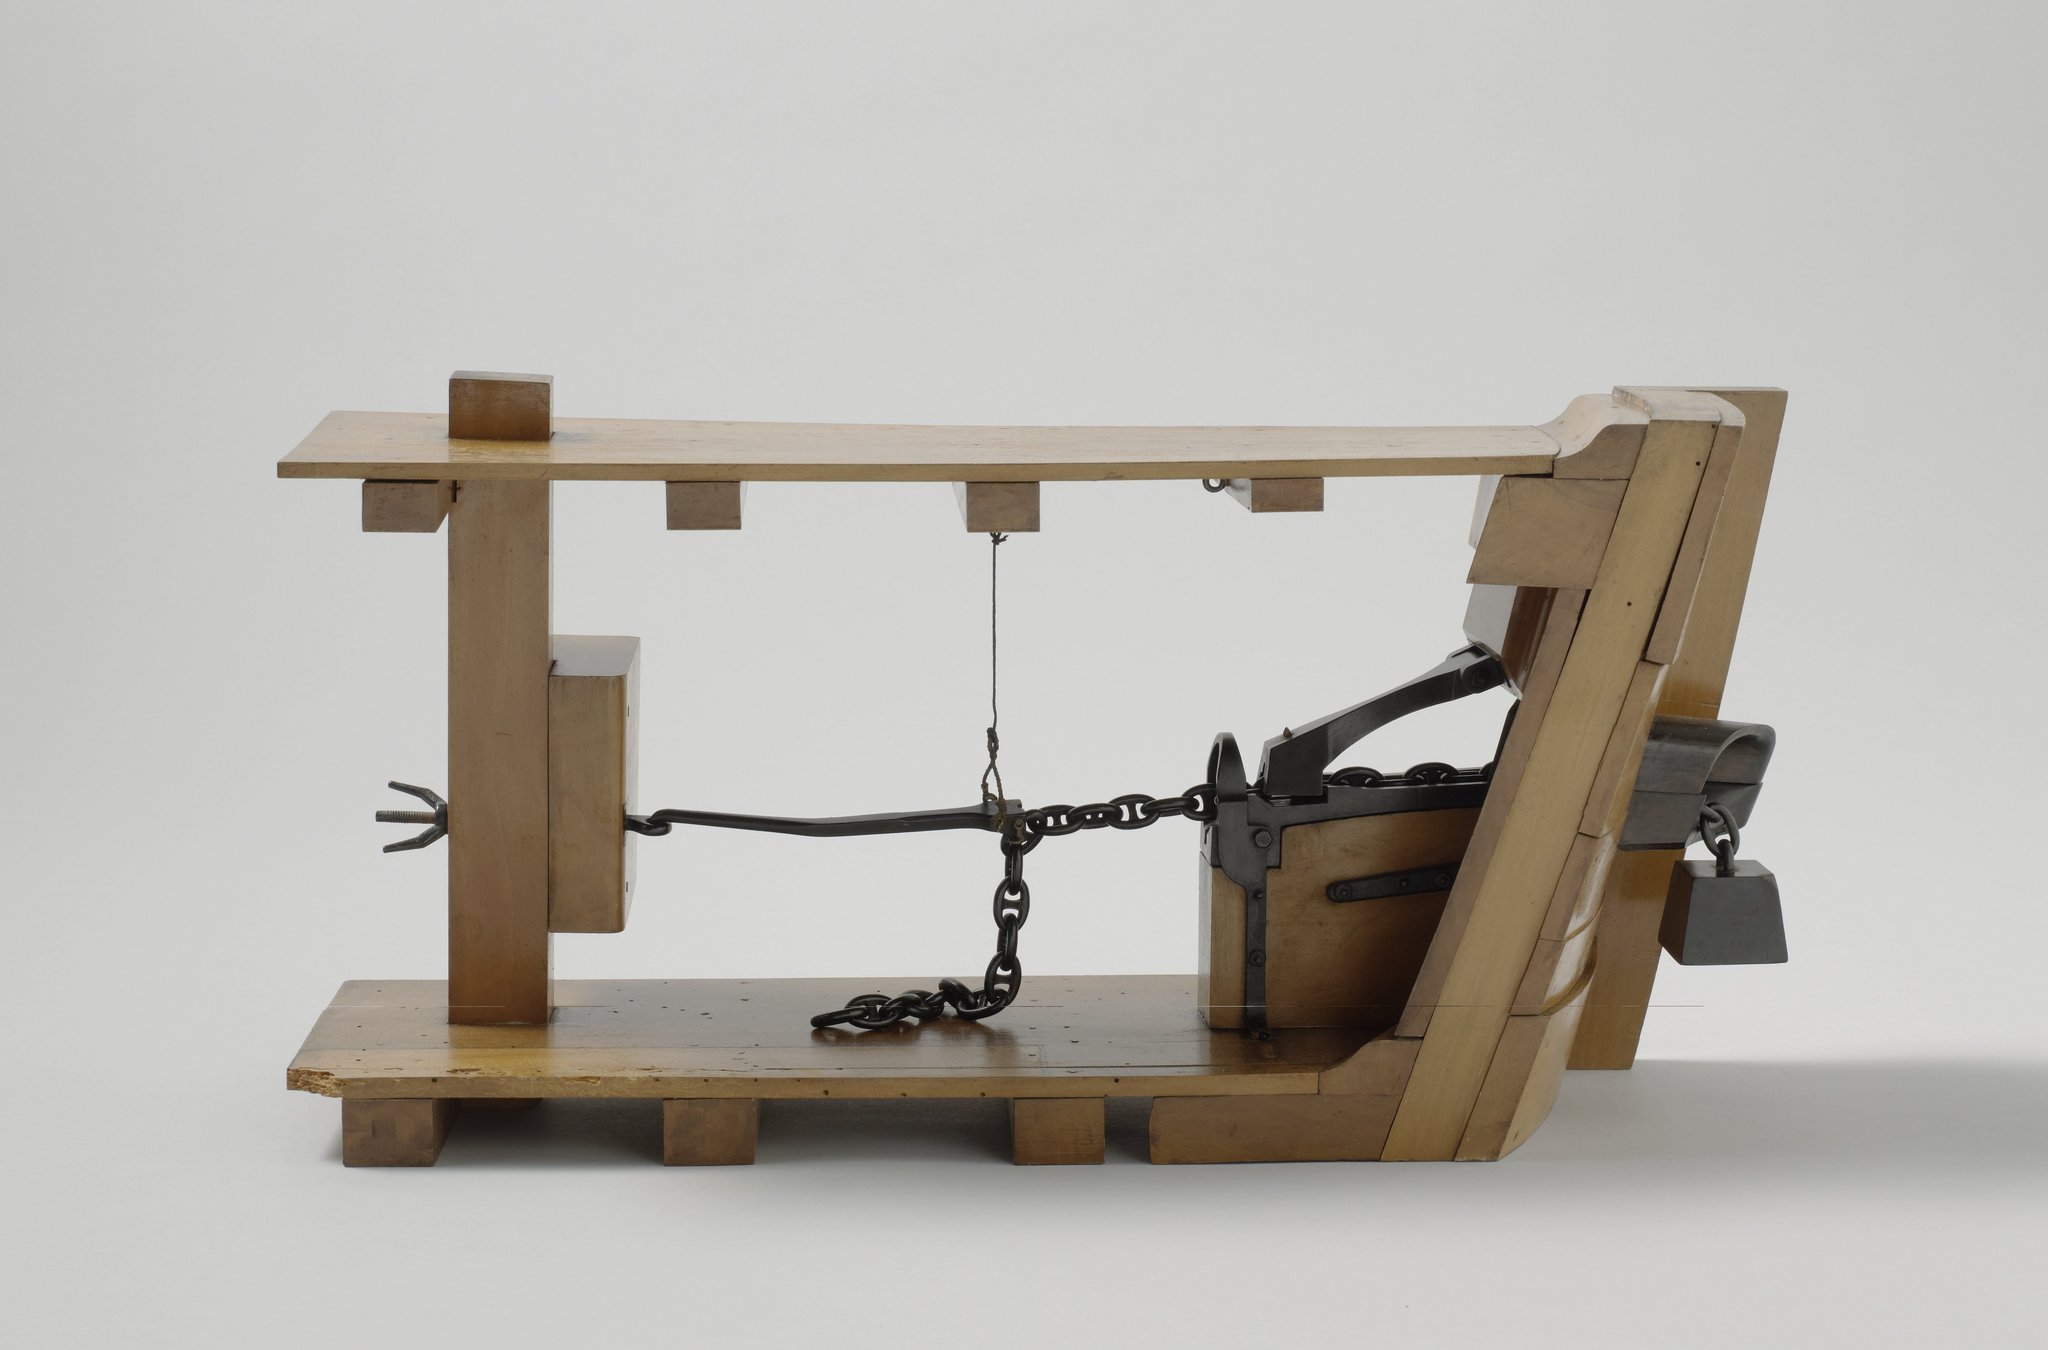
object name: demonstration model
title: Model of a Stopper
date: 1833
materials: wood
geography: flushing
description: Model van een ankerstopper tussen twee dekken, bestaande uit een glijbaan voor de ketting op een klos en doorlopend door het stuurboord kluisgat, en een zware duivelsklauw hangend aan een klos aan de scheepswand. Een lichte duivelsklauw hangt aan een dekbalk en aan een zware klos tegen een dekstut. Een houten ketting met namaakgewicht is aan het model toegevoegd. Schaal 1:10 (schatting).